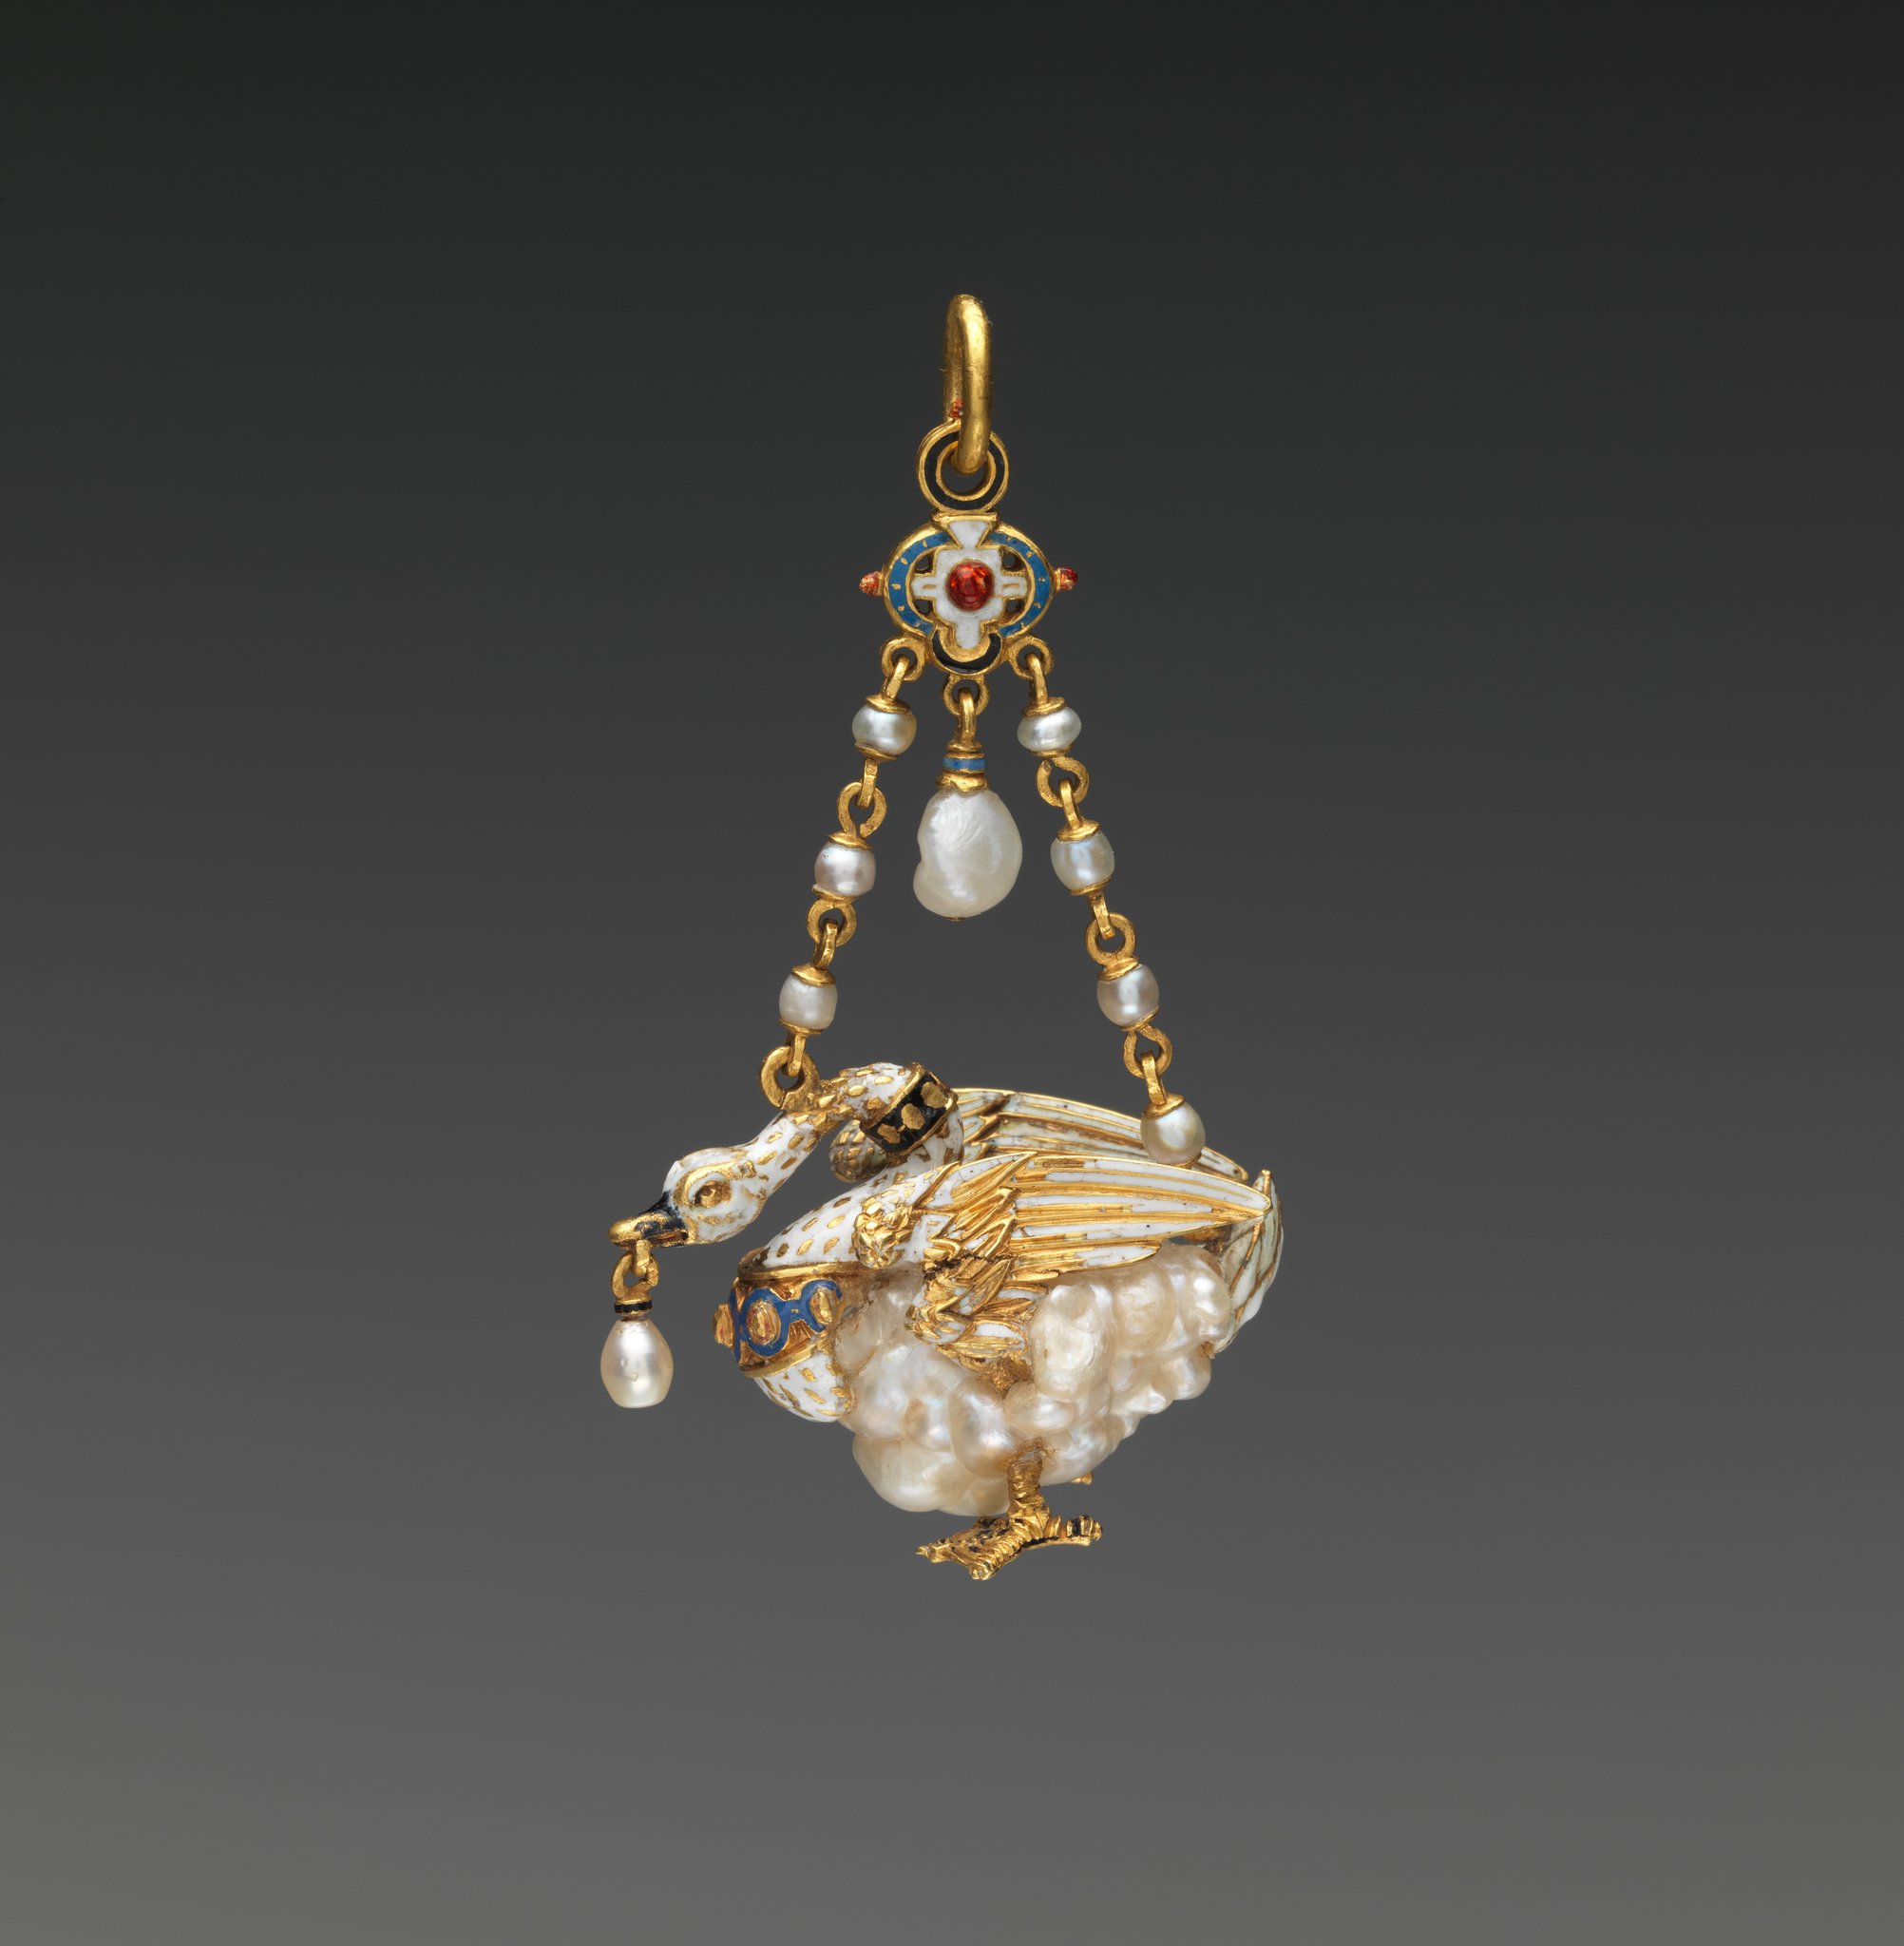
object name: pendant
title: Pendant in the form of a swan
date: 1501-1600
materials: gold, pearl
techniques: enamel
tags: swans